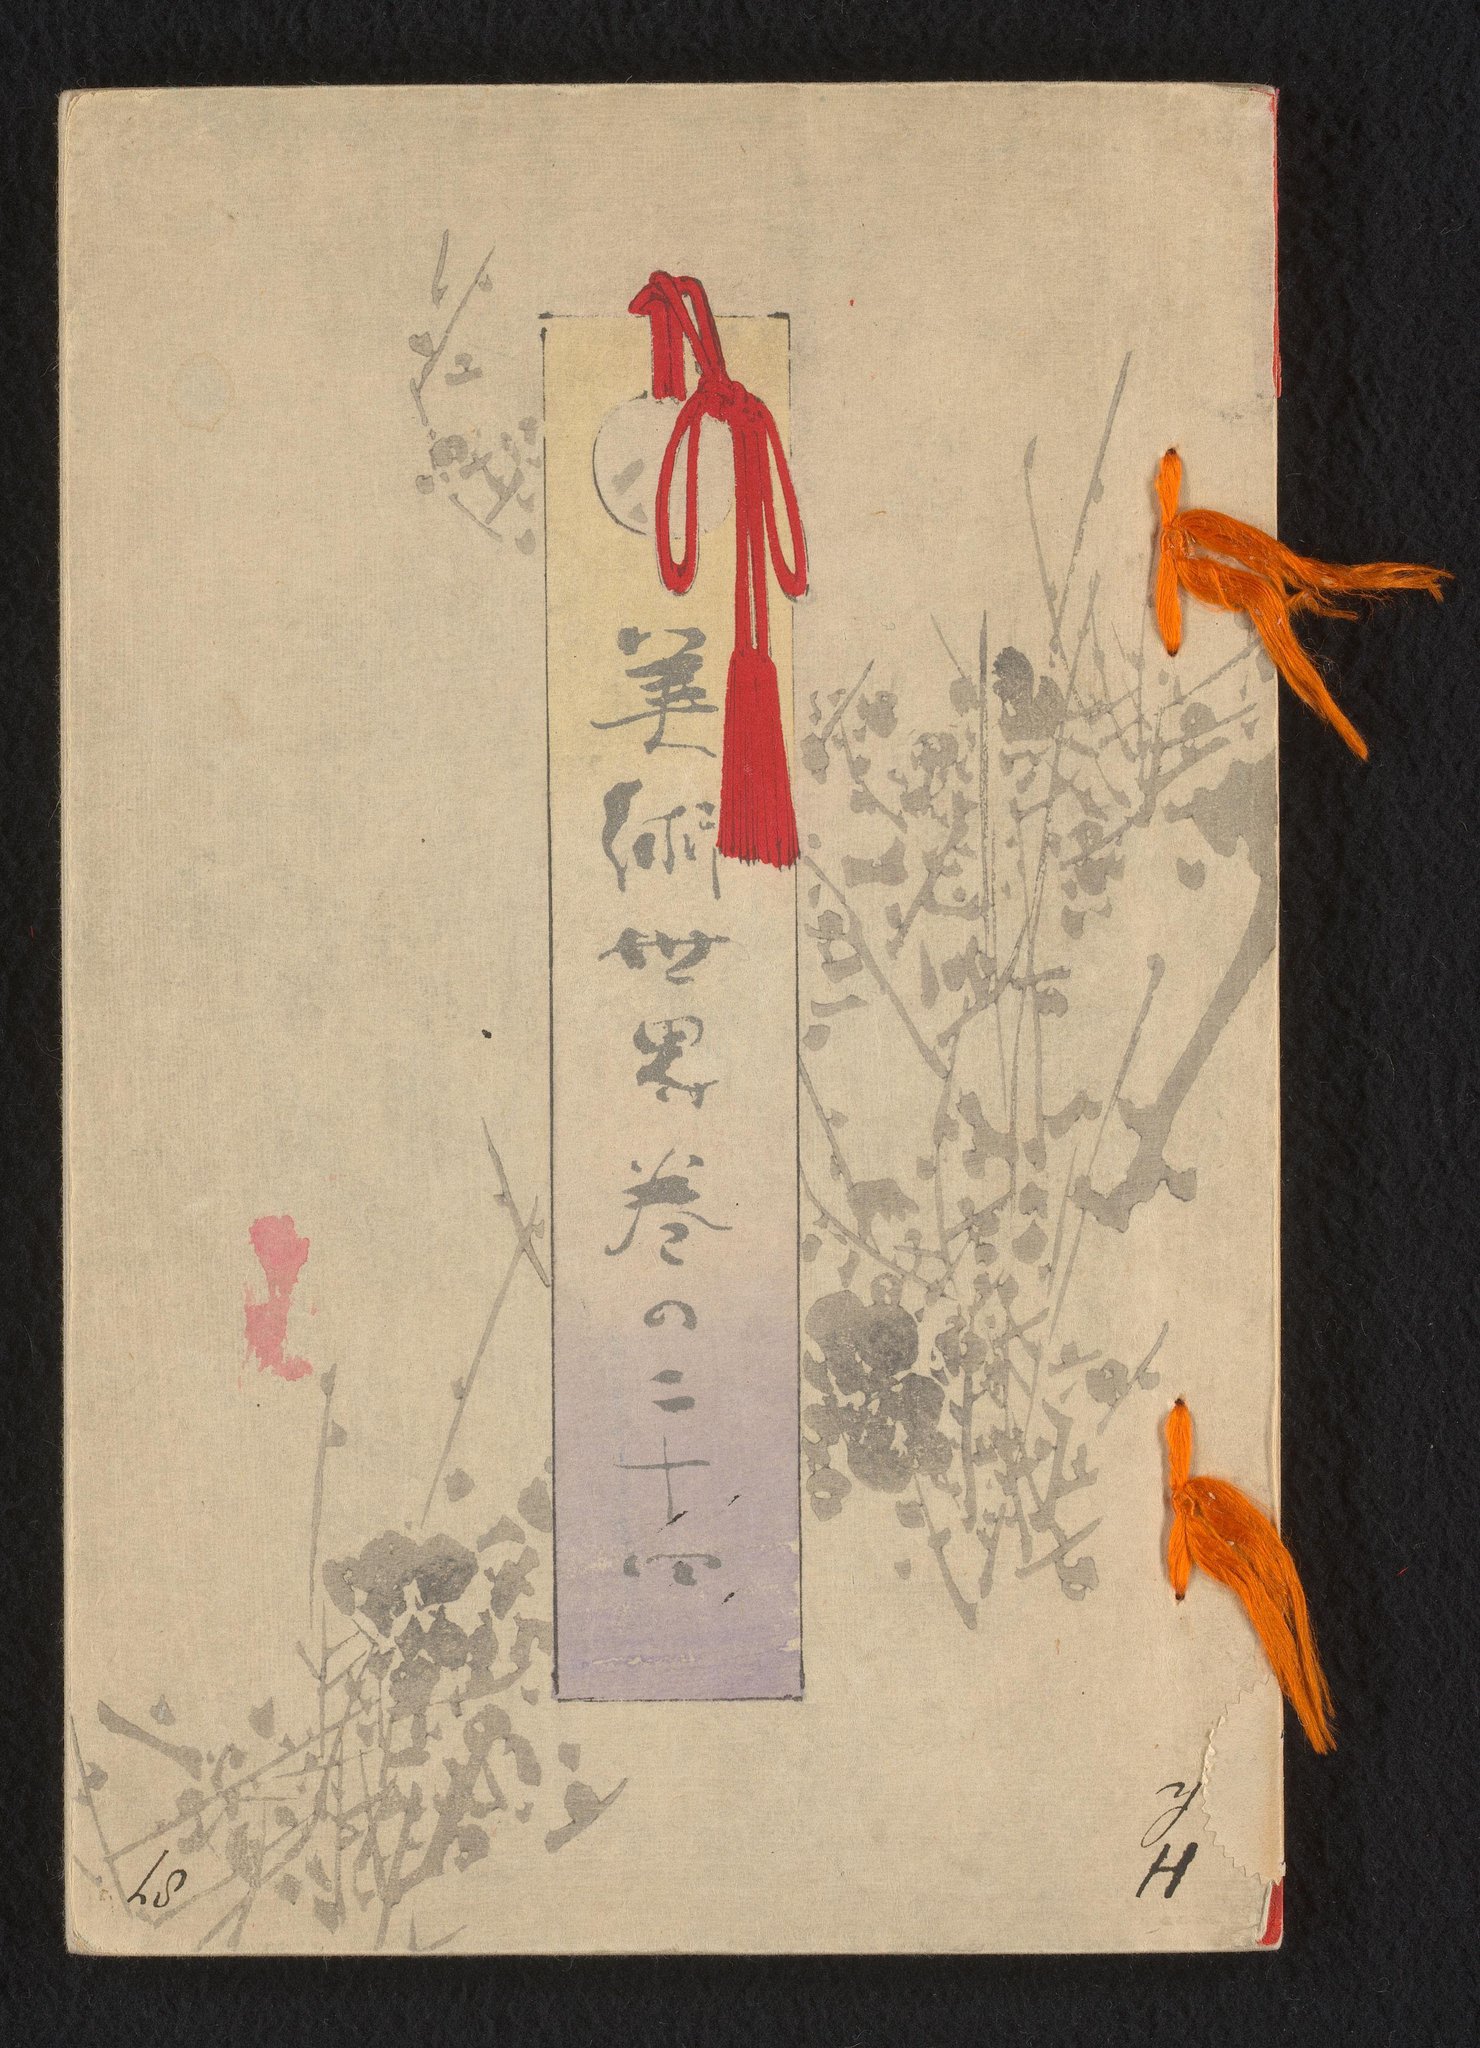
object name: book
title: Bijutsu sekai - 24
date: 1893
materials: paper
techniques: blind stamped, woodcut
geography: tokyo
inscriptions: collector's mark: ‘Rijksschool voor kunstnijverheid’ Lugt 3937